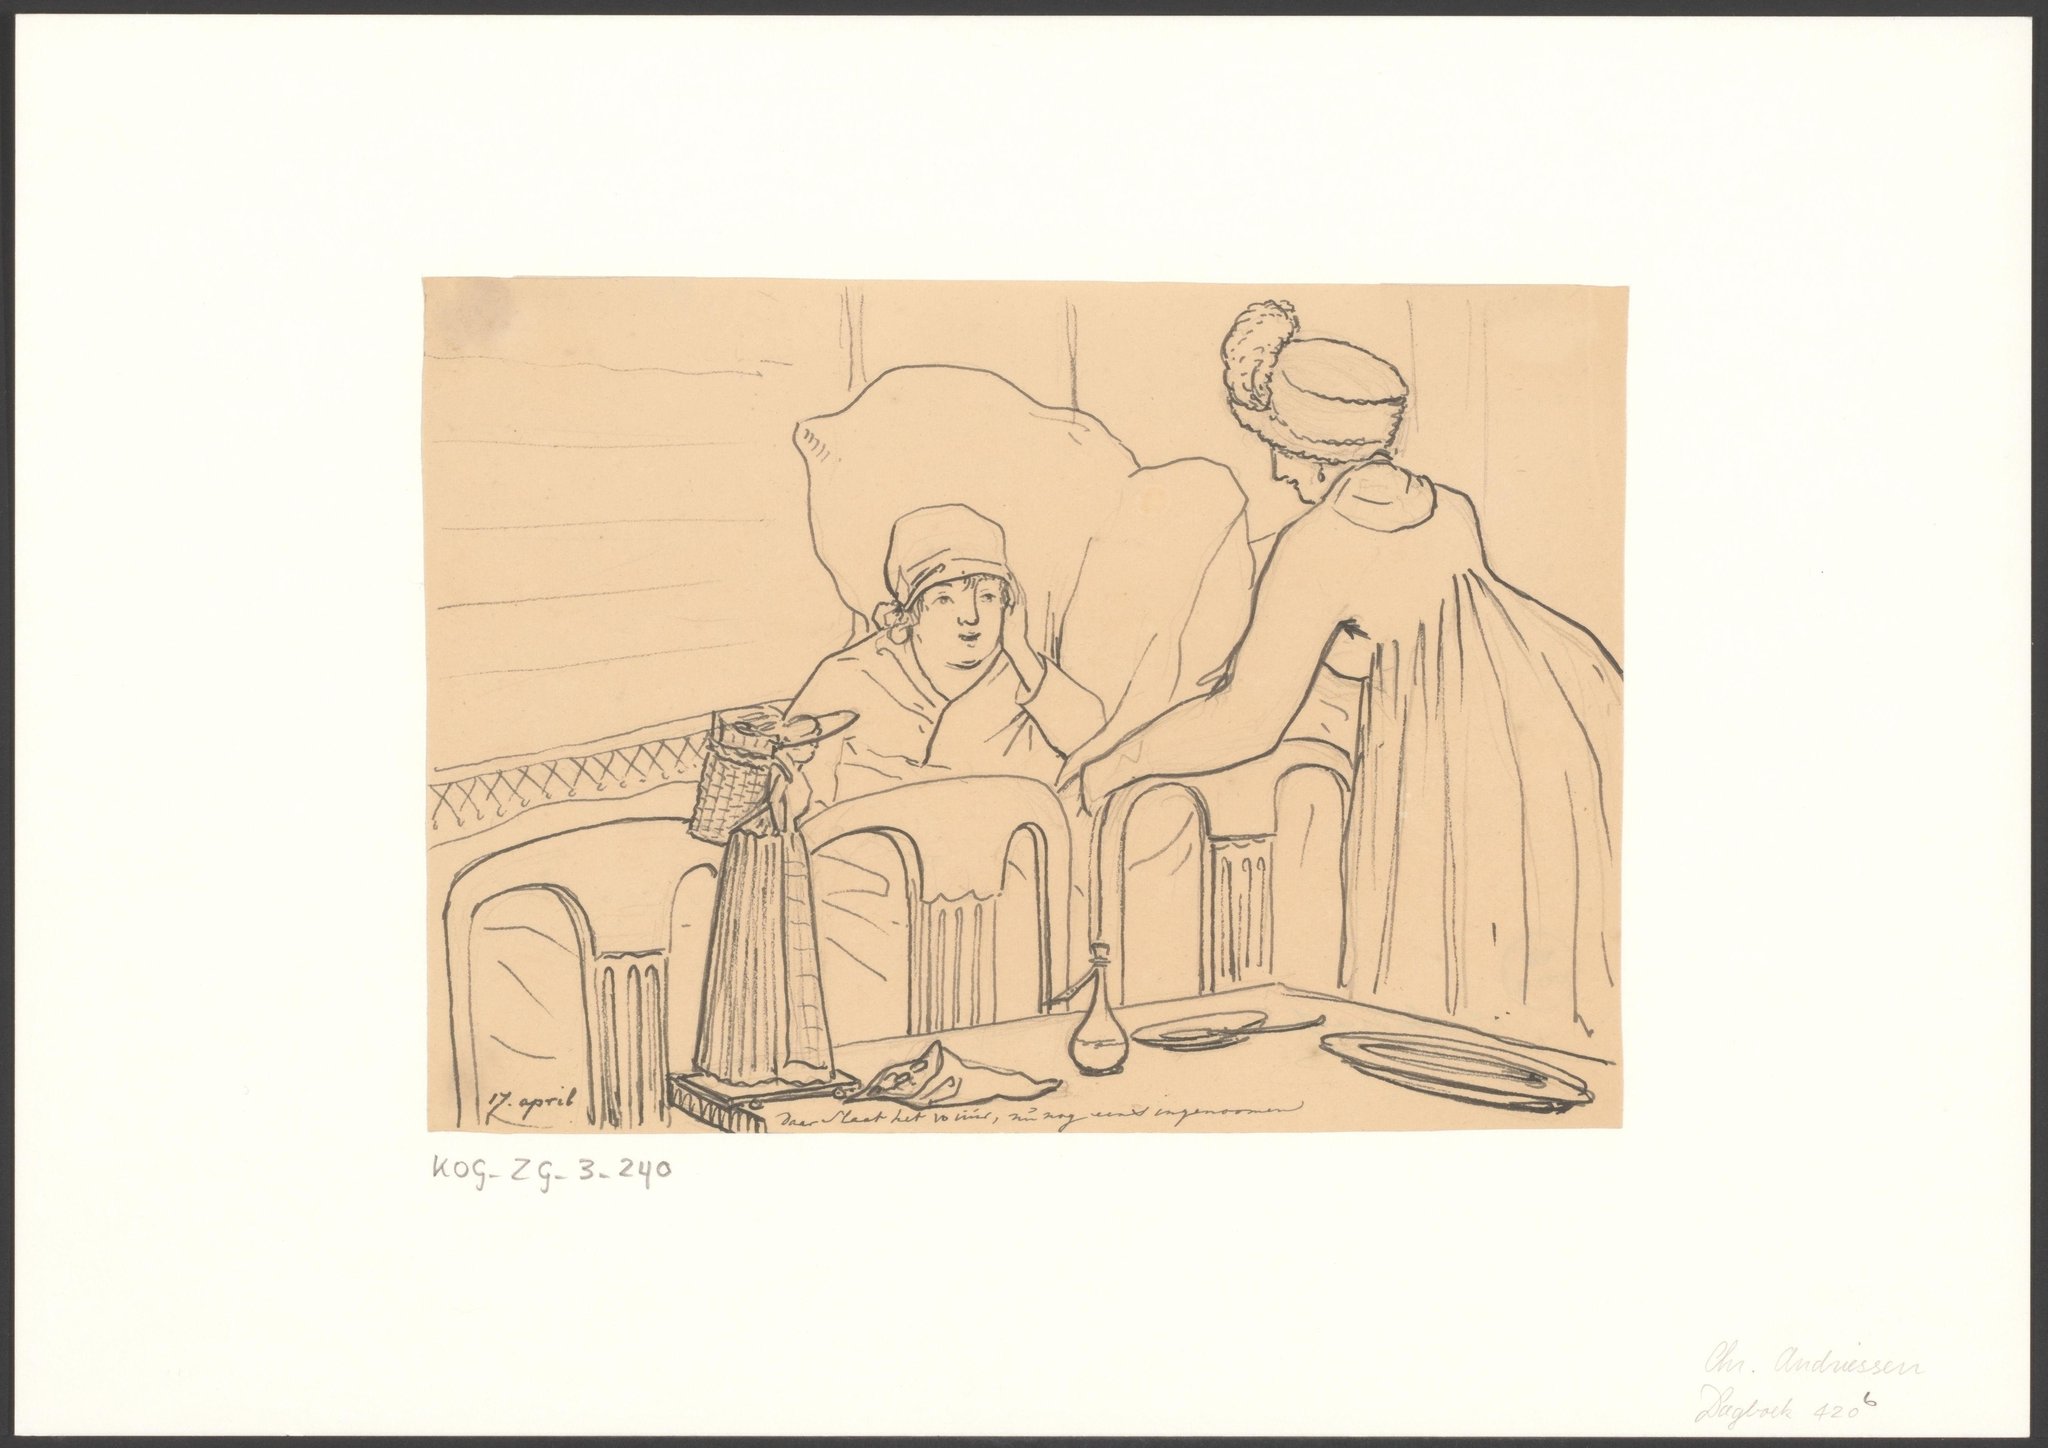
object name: drawing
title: Zieke vrouw krijgt medicijnen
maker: christiaan andriessen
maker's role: draughtsman, print maker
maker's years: 1775-1846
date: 1805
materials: ink, paper, pencil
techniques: pen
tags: sick-bed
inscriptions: signature: ‘J Andriessen’, inscription: ‘17 april daar slaat het tien uur, nu nog eens ingenomen’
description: Dagboekblad uit het getekende dagboek dat Christiaan Andriessen bijhield van 1805 tot en met 1808.